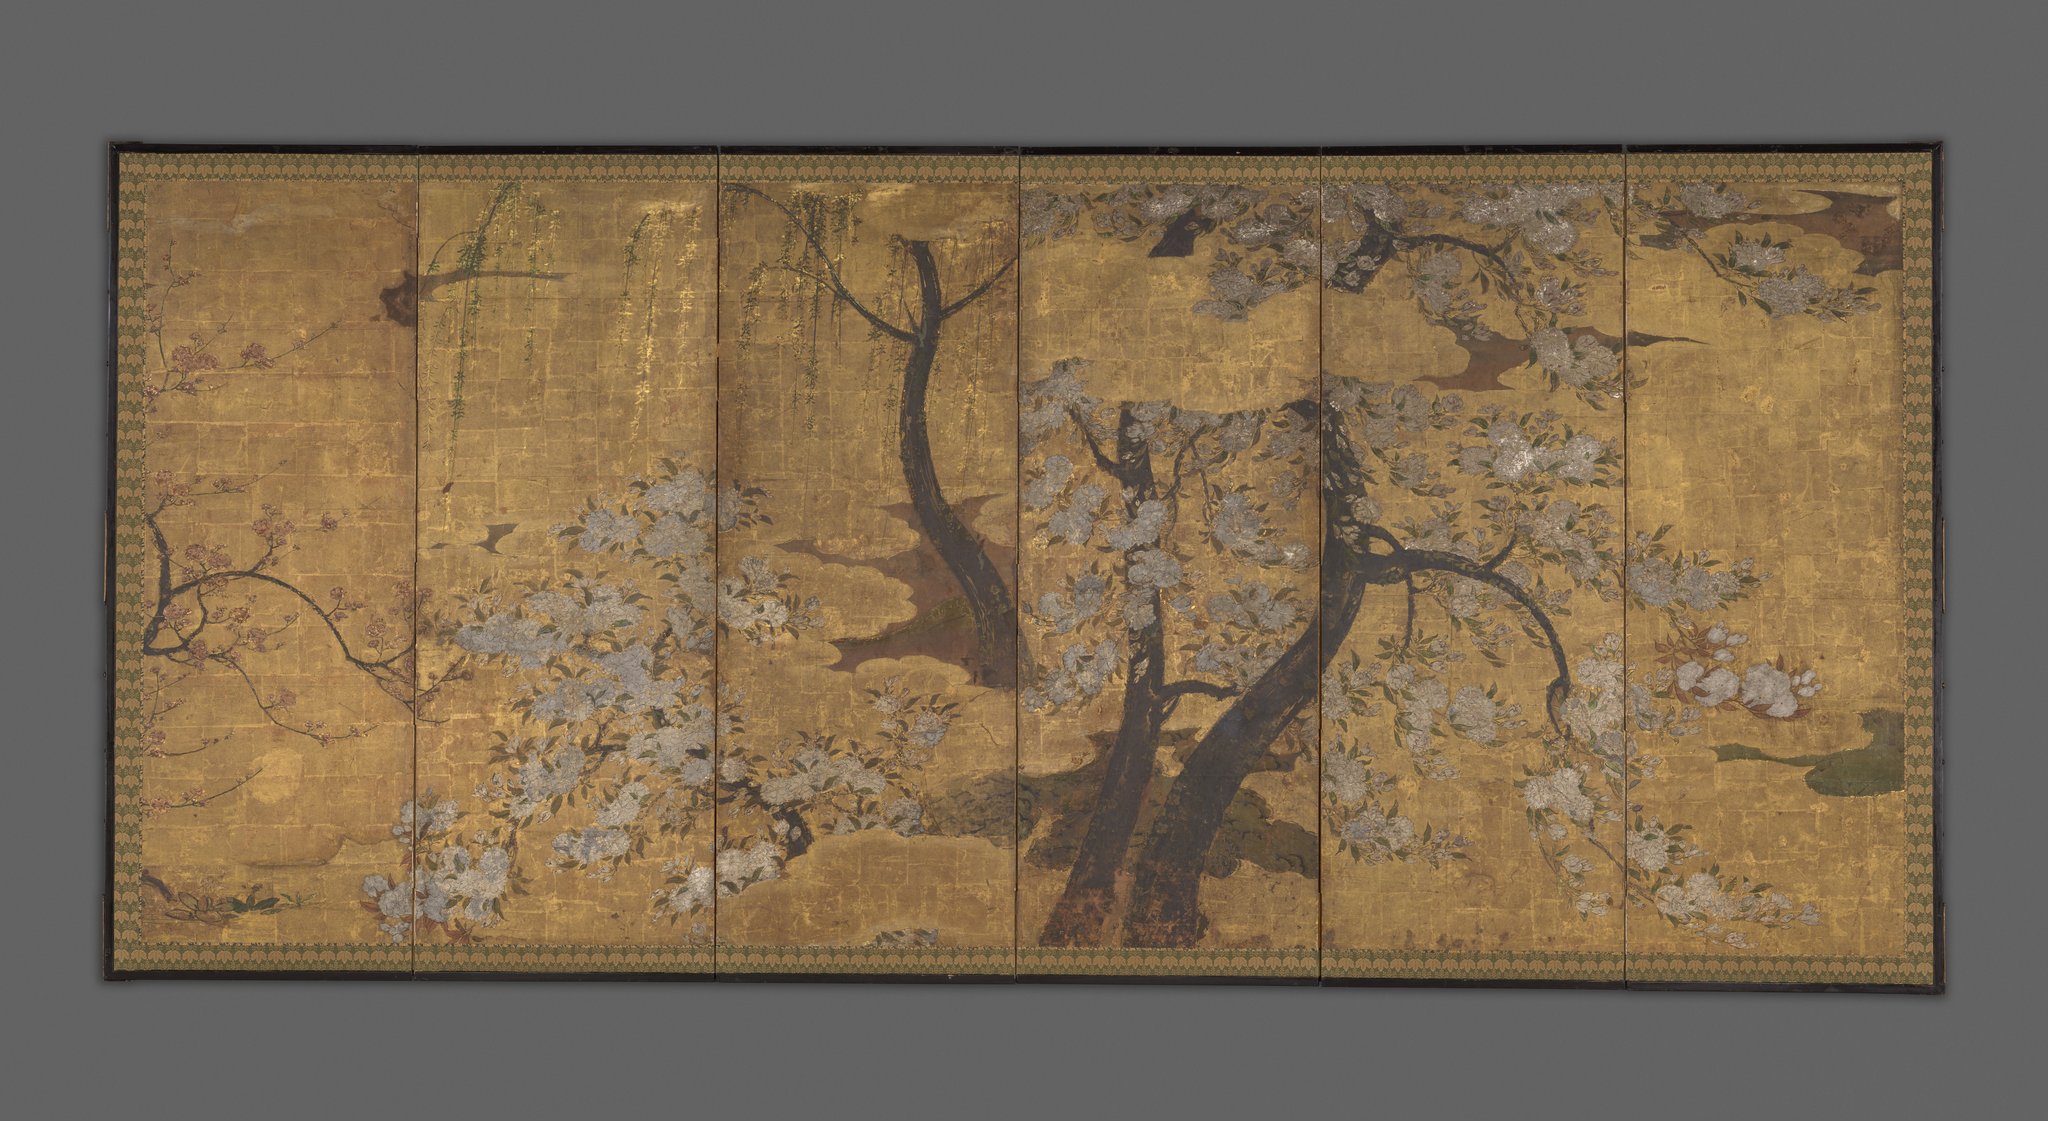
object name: screen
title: Cherry, Plum and Willow Trees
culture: japanese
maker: unidentified artist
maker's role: artist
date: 1601-1633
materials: gold, gold leaf, ink, panel, paper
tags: trees